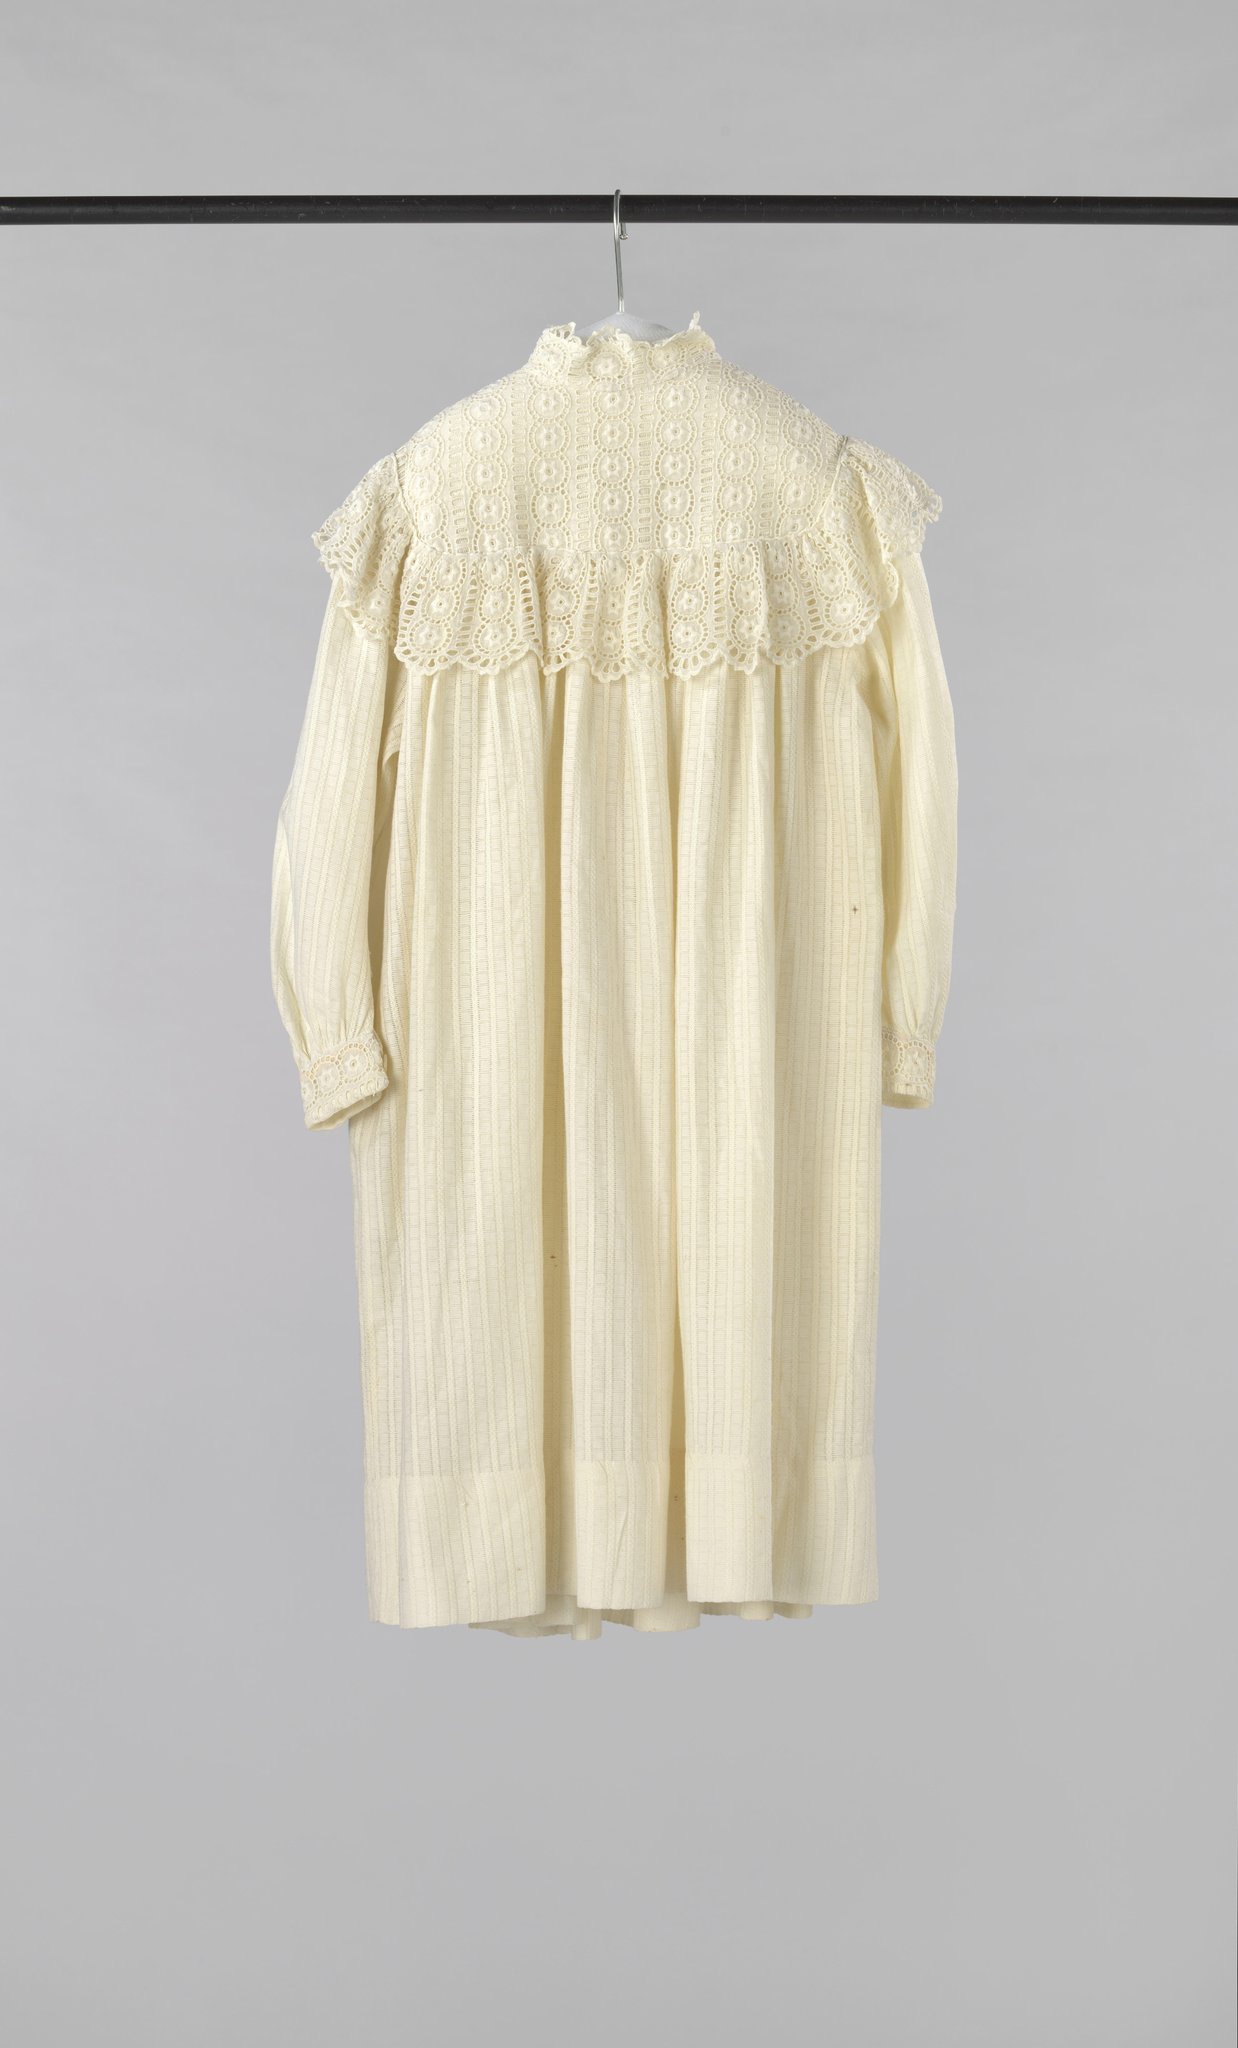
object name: girls' wear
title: Meisjesjurk met lange mouw, van gedessineerd neteldoek (?) met streepjes- en blokmotiefjes; versierd met pas en strook van randstof met machinal Engels borduurwerk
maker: Anonymous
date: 1907-1910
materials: textile, cotton, mother of pearl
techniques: cross stitching, embroidered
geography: switzerland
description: Een meisjesjurk met lange mouw, van gedessineerd neteldoek (?) met streepjes- en blokmotiefjes; versierd met pas en strook van randstof met machinal Engels borduurwerk. Achtersluiting met sierparelmoeren knopen en lusjes.